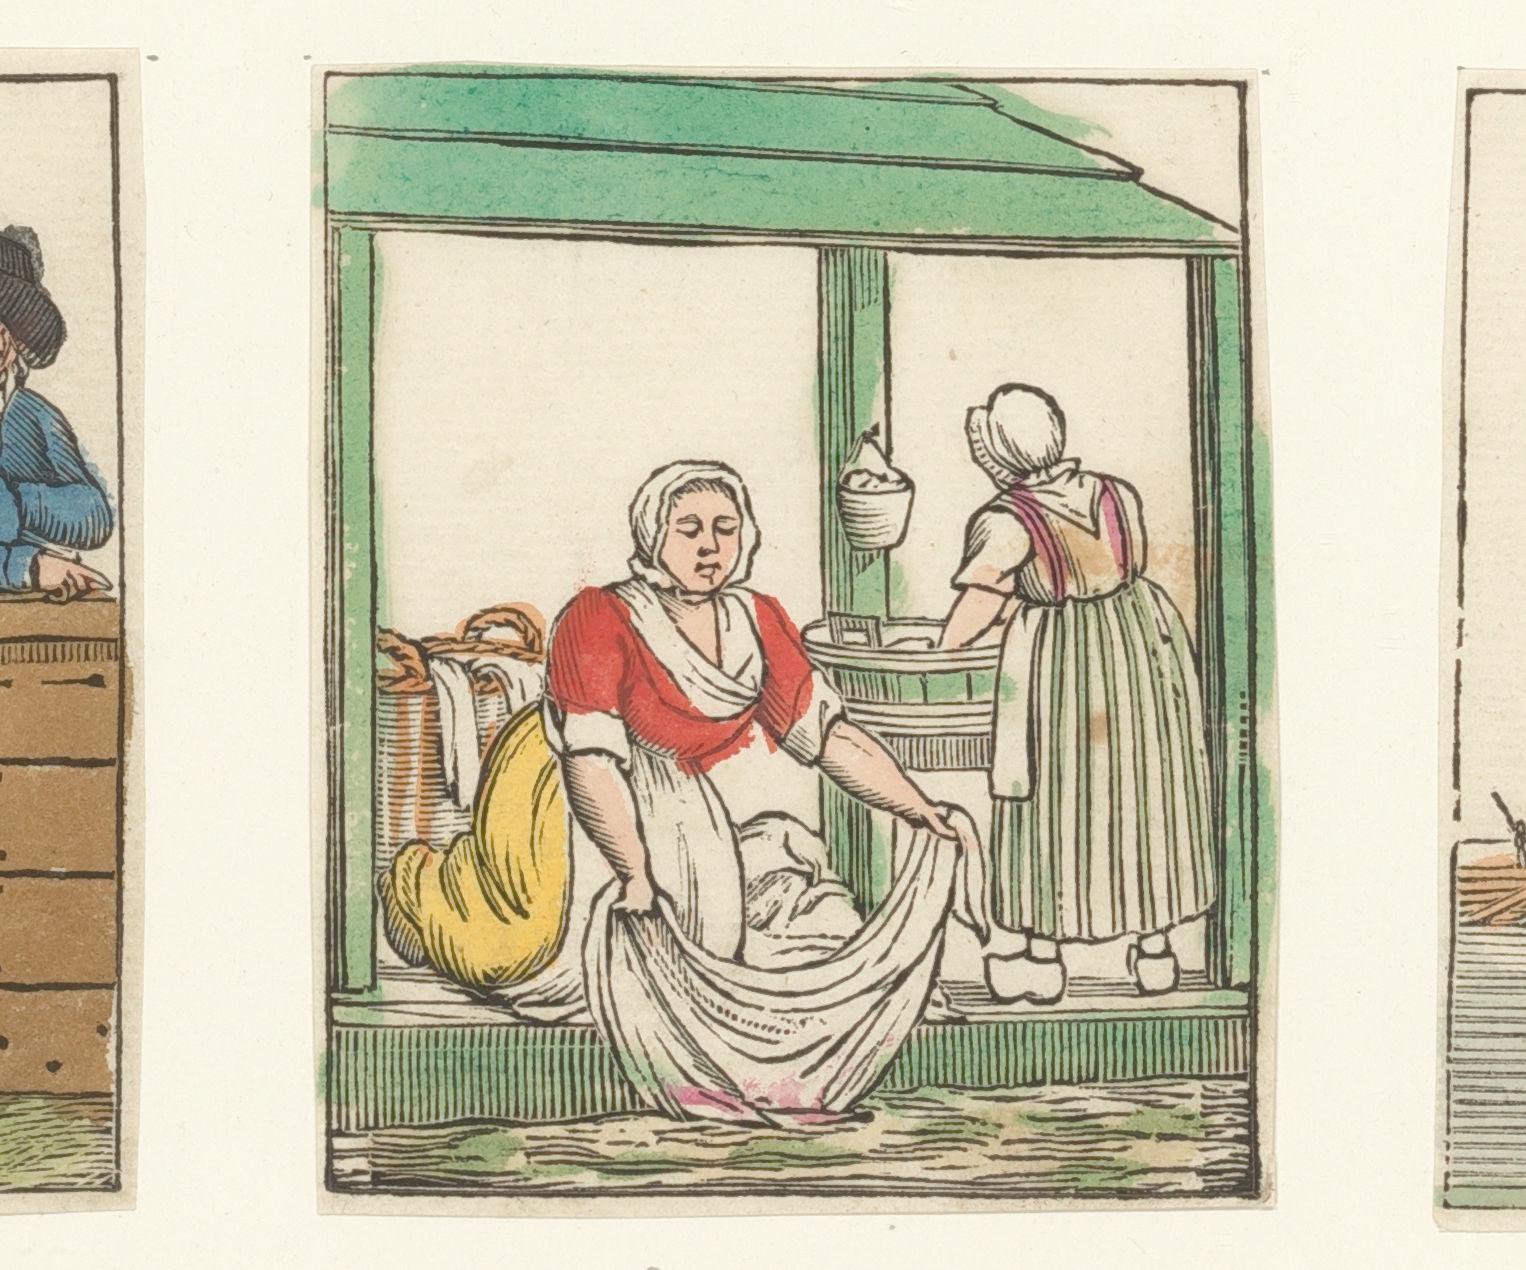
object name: print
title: Twee wasvrouwen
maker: Anonymous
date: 1827-1830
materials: paper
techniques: hand coloring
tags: laundering, building or outbuilding where laundry is done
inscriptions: collector's mark: Lugt 1641, stamp, collector's mark: Lugt 1641a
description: Twee wasvrouwen onder een afdakje. De ene staat bij tobbe, de andere spoelt de was uit. Onderwerpsrubrieken binnen de Atlas Zeden en Gewoonten: Handel, Nijverheid en Verkeer, Beroep en bedrijf, Complete suites.